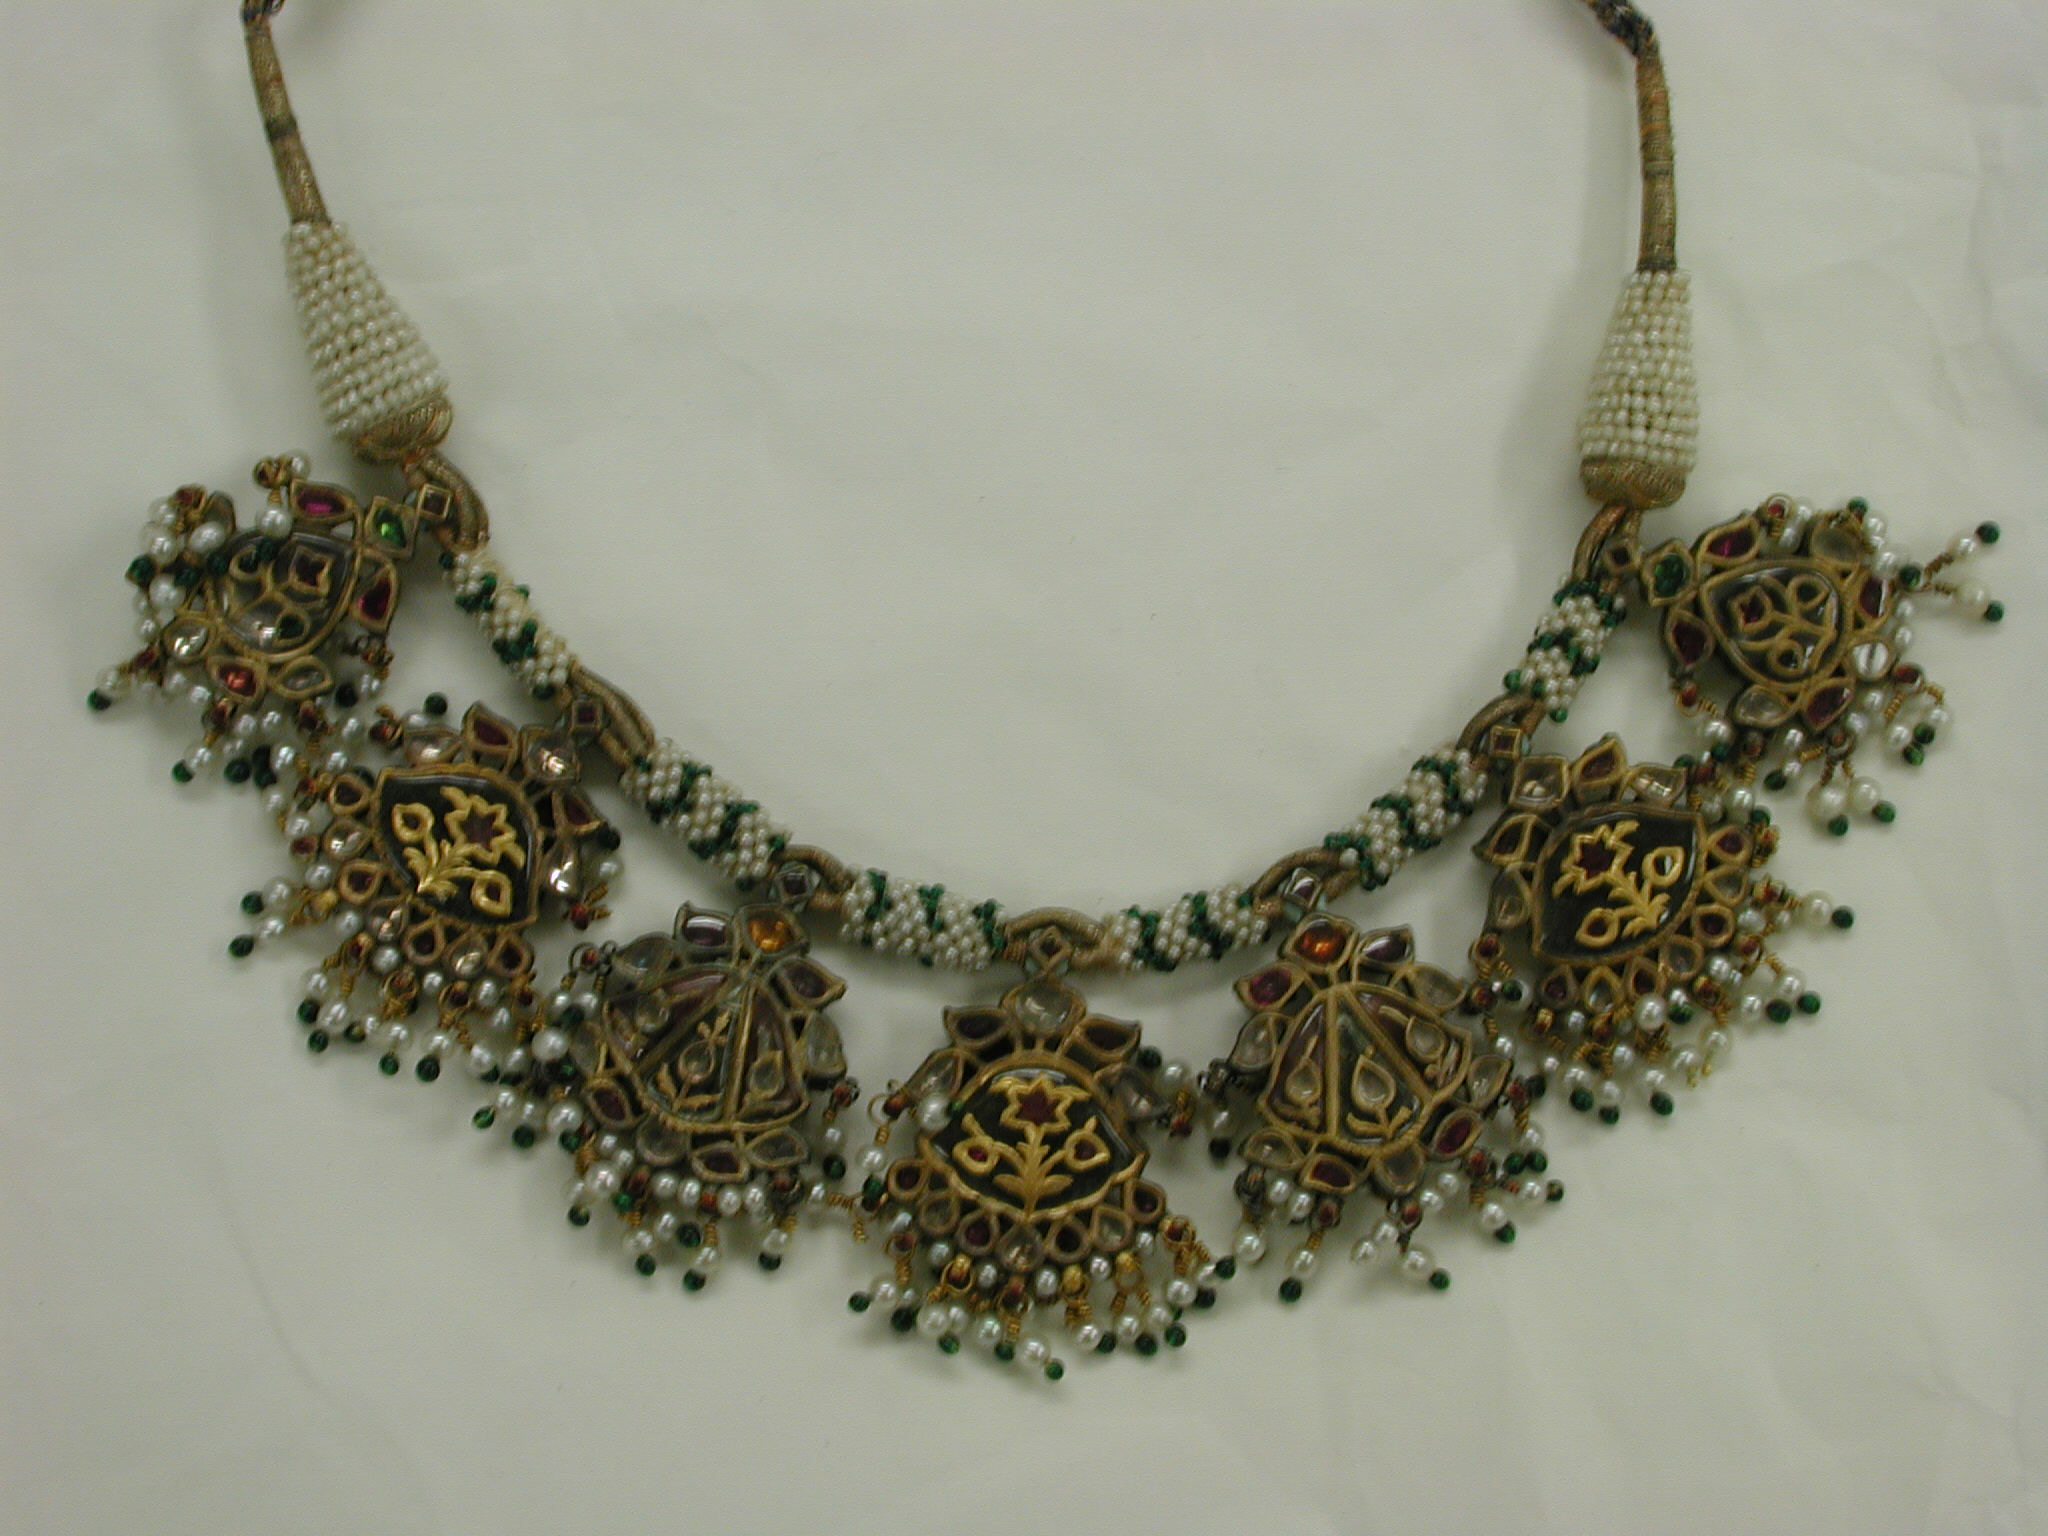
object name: necklace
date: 1701-1900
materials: gold, pearl, stone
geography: northern india